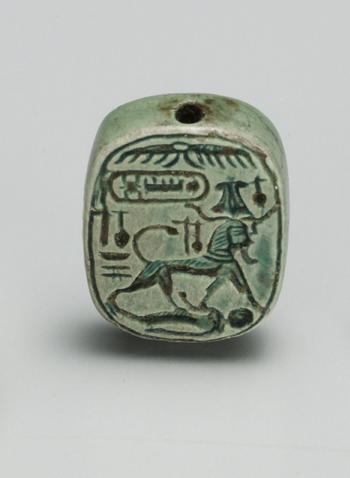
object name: plaque, thutmose iii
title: Plaque inscribed for Thutmose III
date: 1479-1425 BCE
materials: stone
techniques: glazing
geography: egypt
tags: hieroglyphs,sphinx